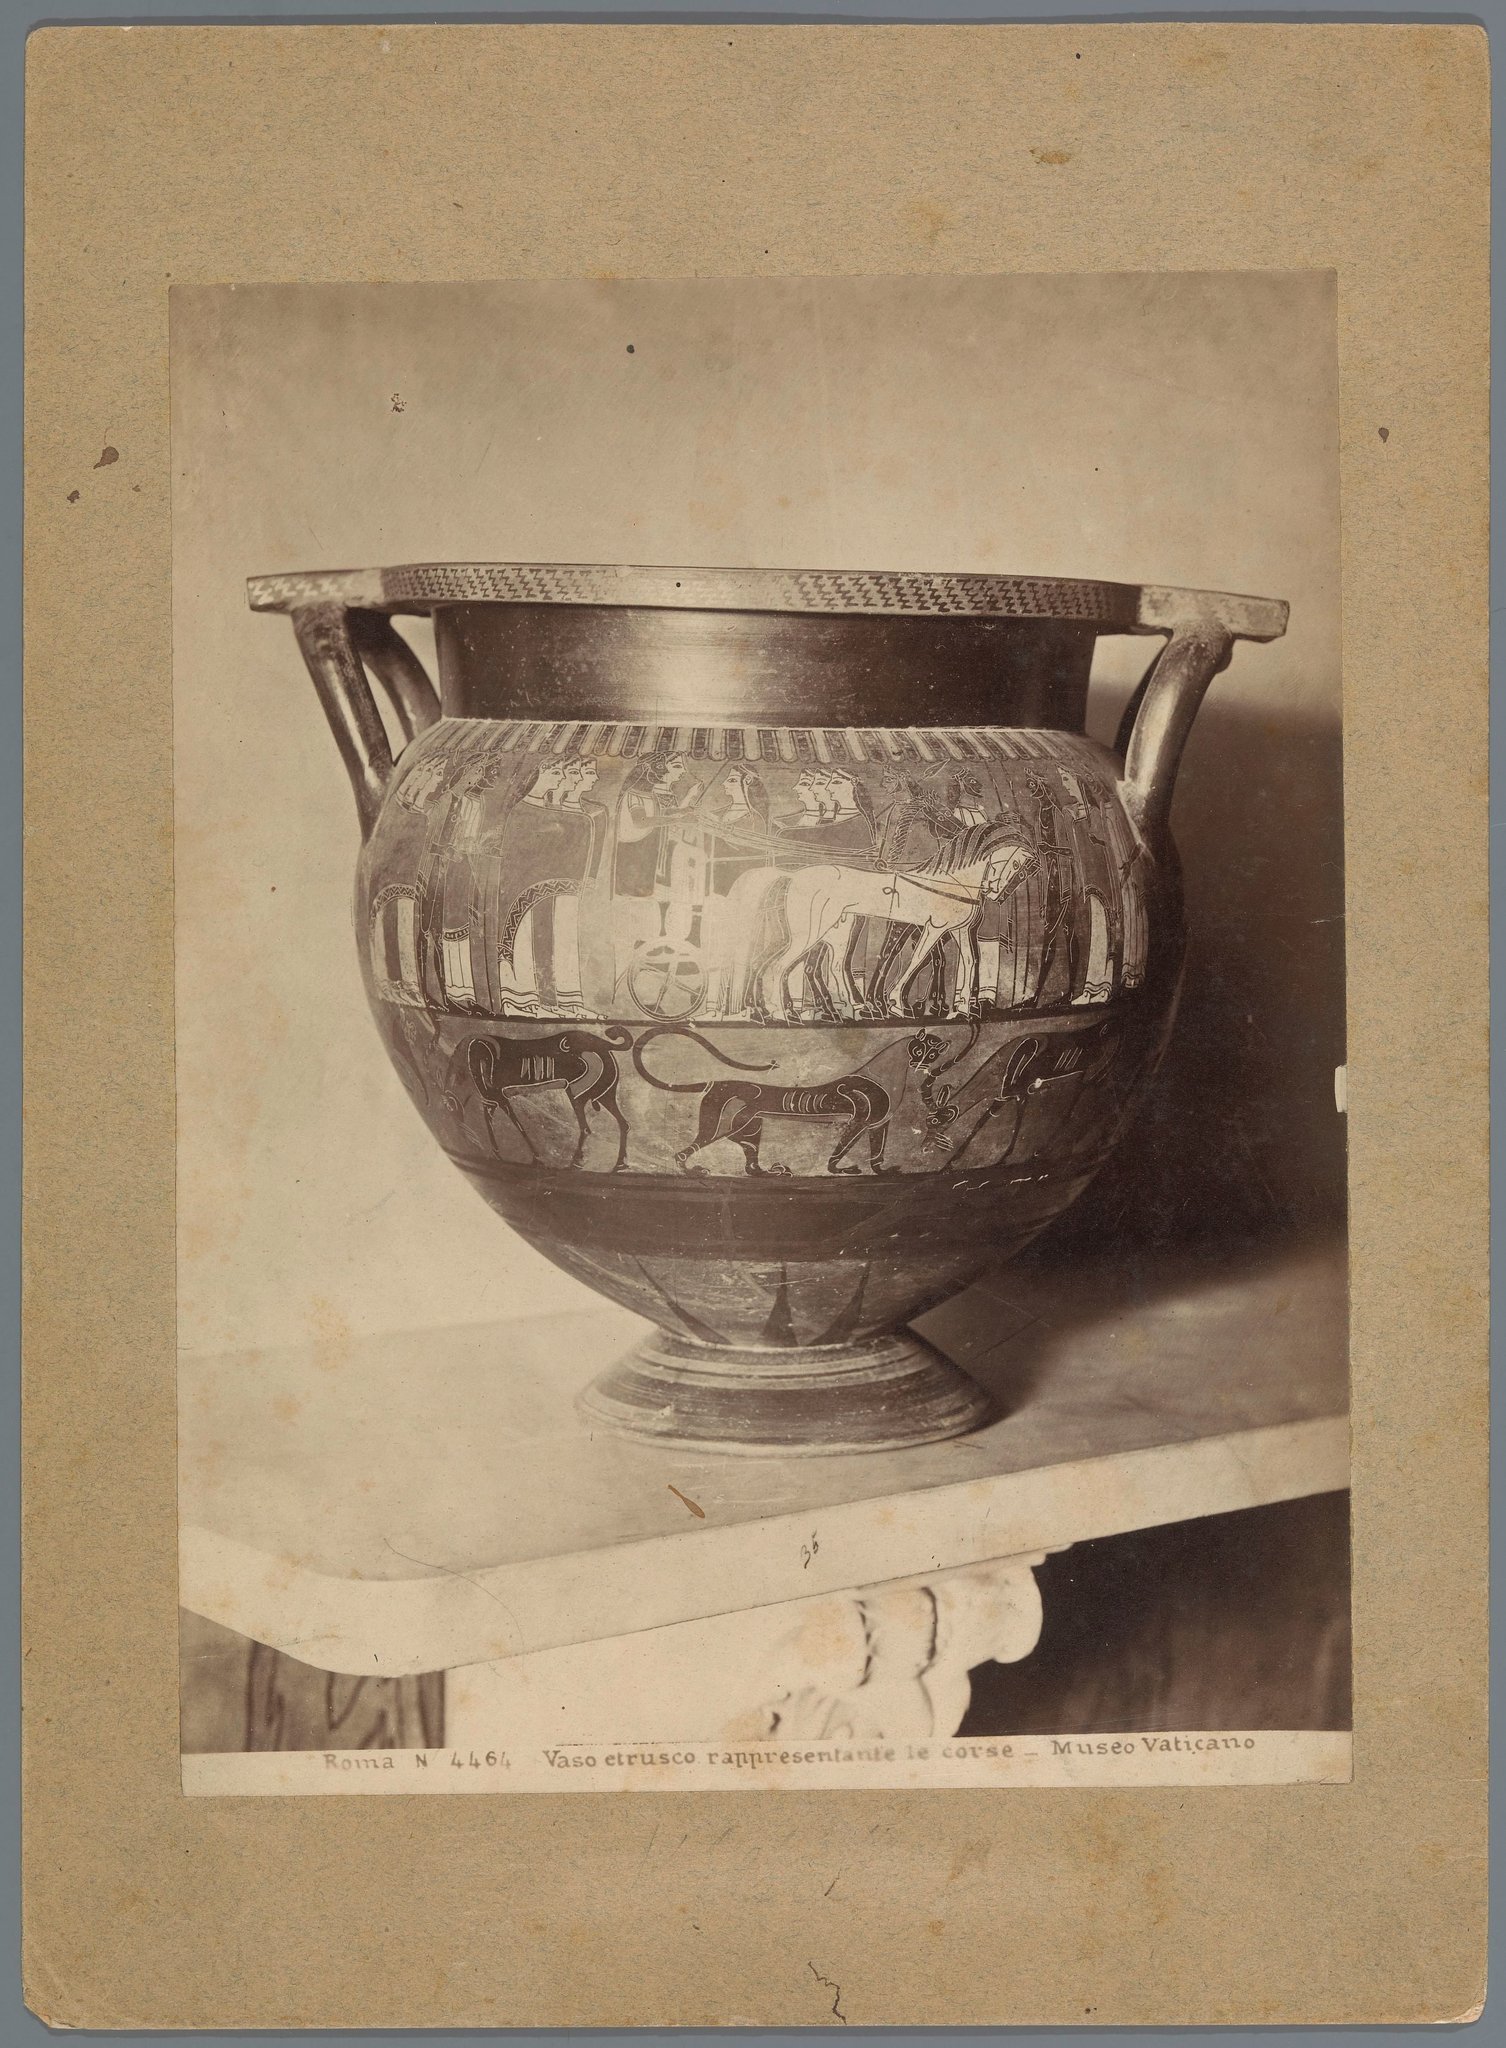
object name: photograph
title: Etruskische vaas gedecoreerd met vrouwen en dieren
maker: Anonymous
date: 1875-1900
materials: cardboard, photographic support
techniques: albumen print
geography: rome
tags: horse, container of stone: stone vase, italy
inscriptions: number: ‘N 4464’, collector's mark: Lugt 3937